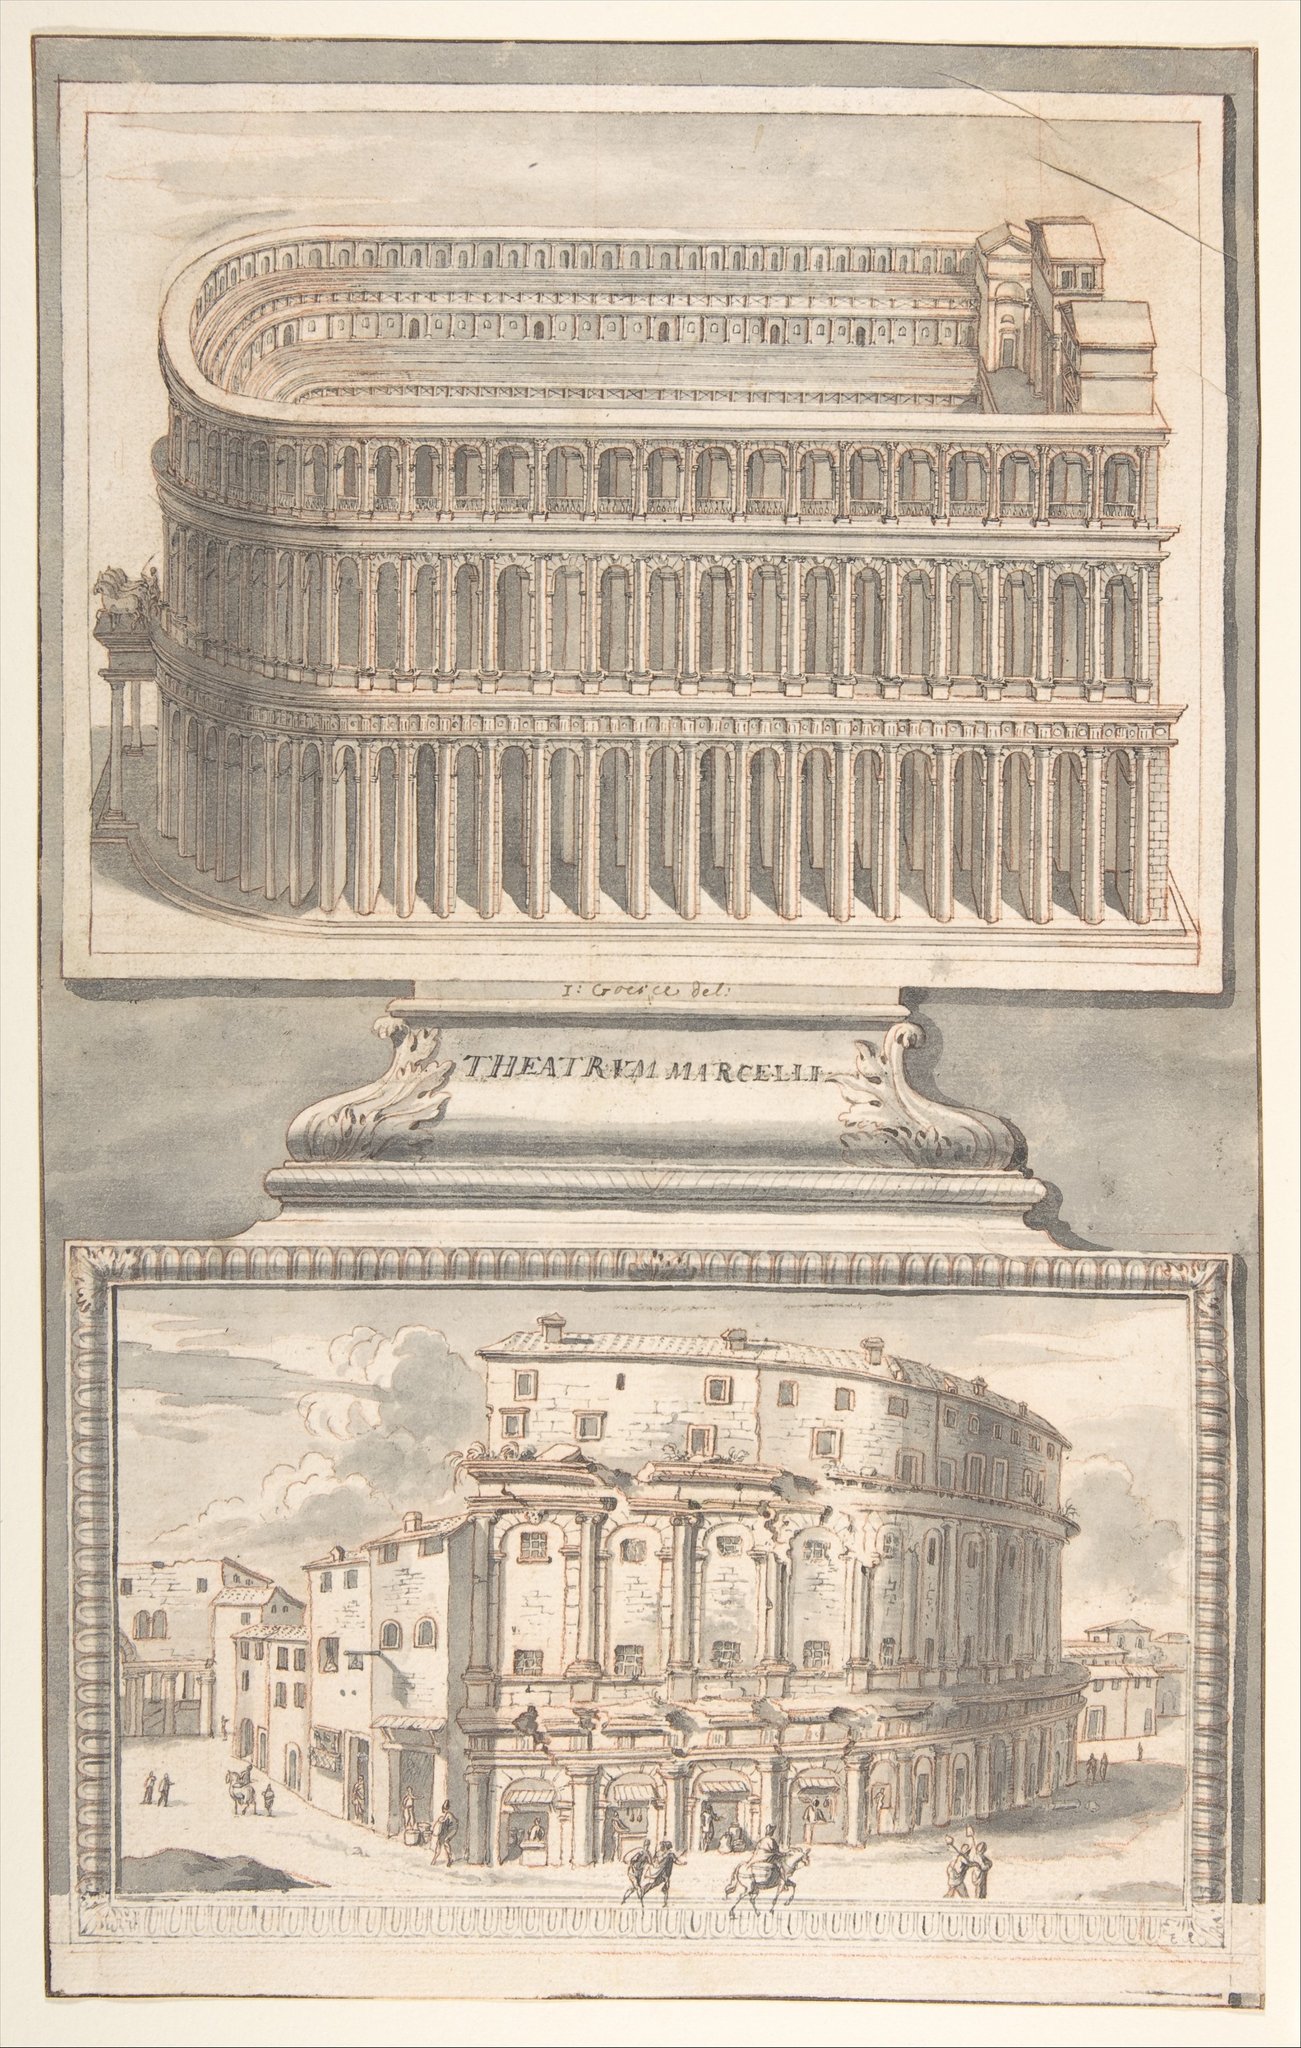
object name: drawing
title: Reconstruction of the Theatre of Marcellus (above) and a View of the Ruins (below)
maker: jan goeree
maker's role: artist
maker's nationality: dutch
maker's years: 1670-1731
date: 1704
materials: chalk, ink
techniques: brush, incising, pen, wash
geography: italy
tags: buildings,ruins,horses